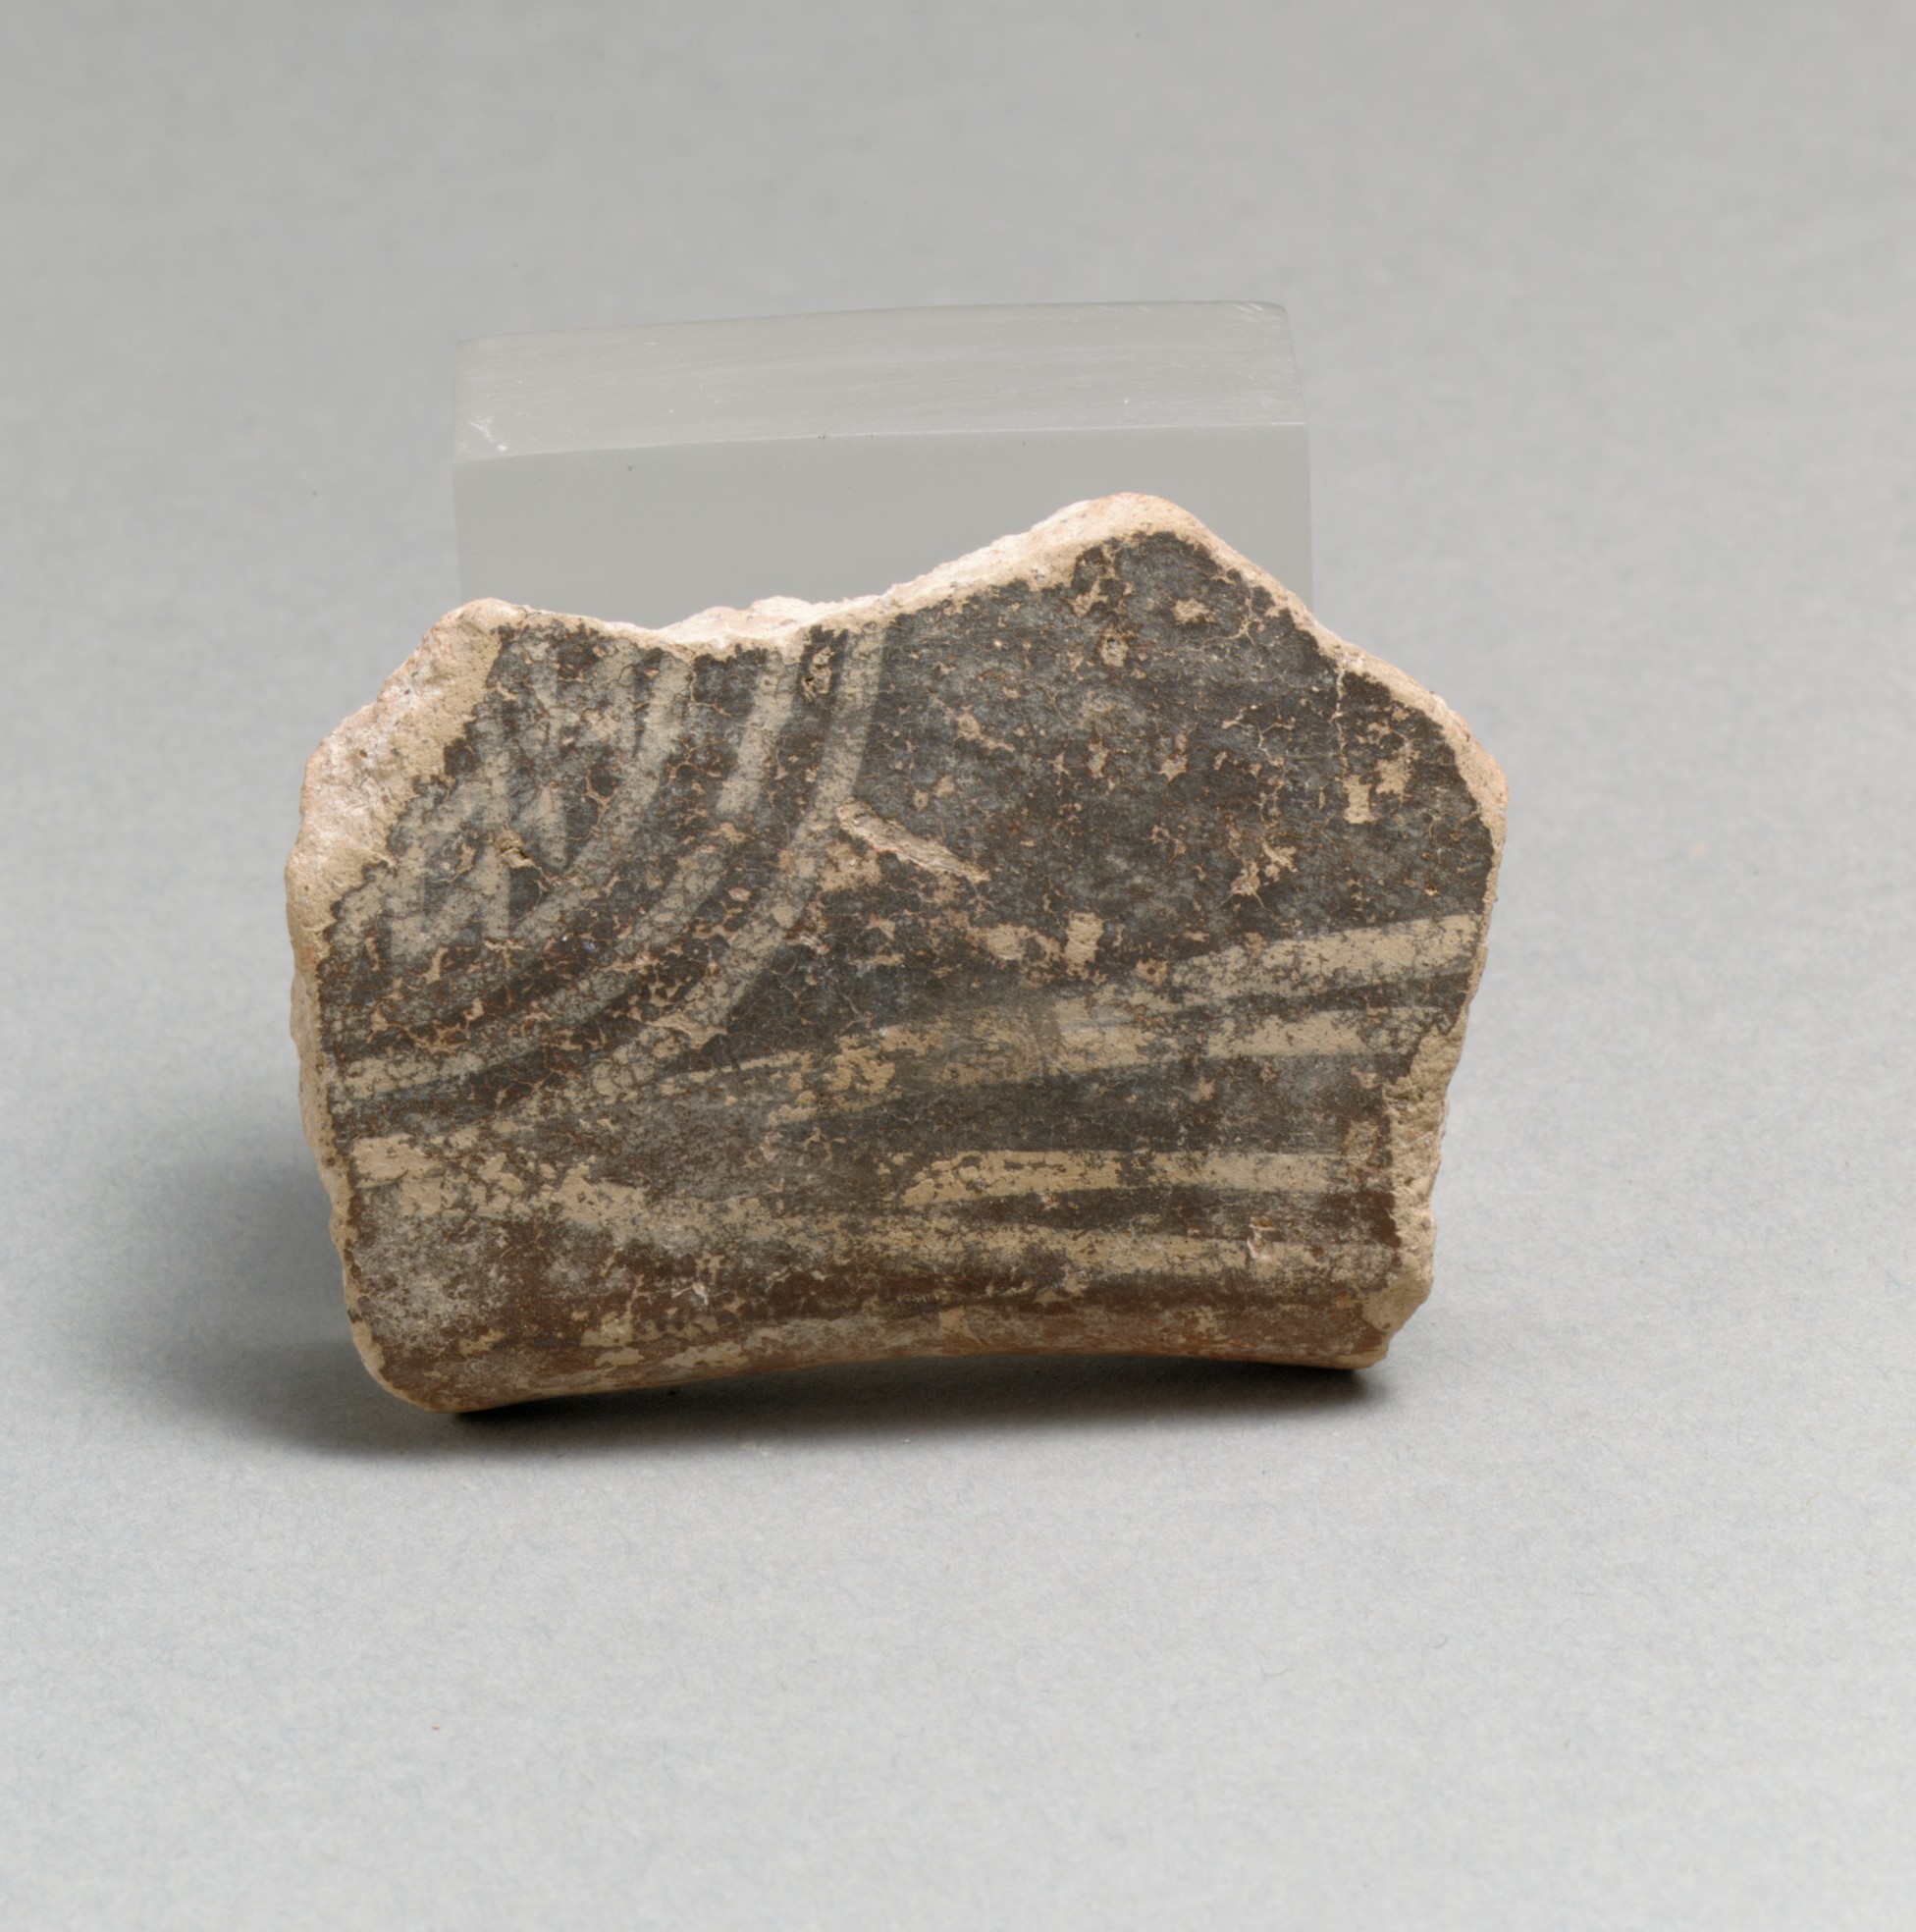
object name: vase fragment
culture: minoan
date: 2600-2000 BCE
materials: terracotta